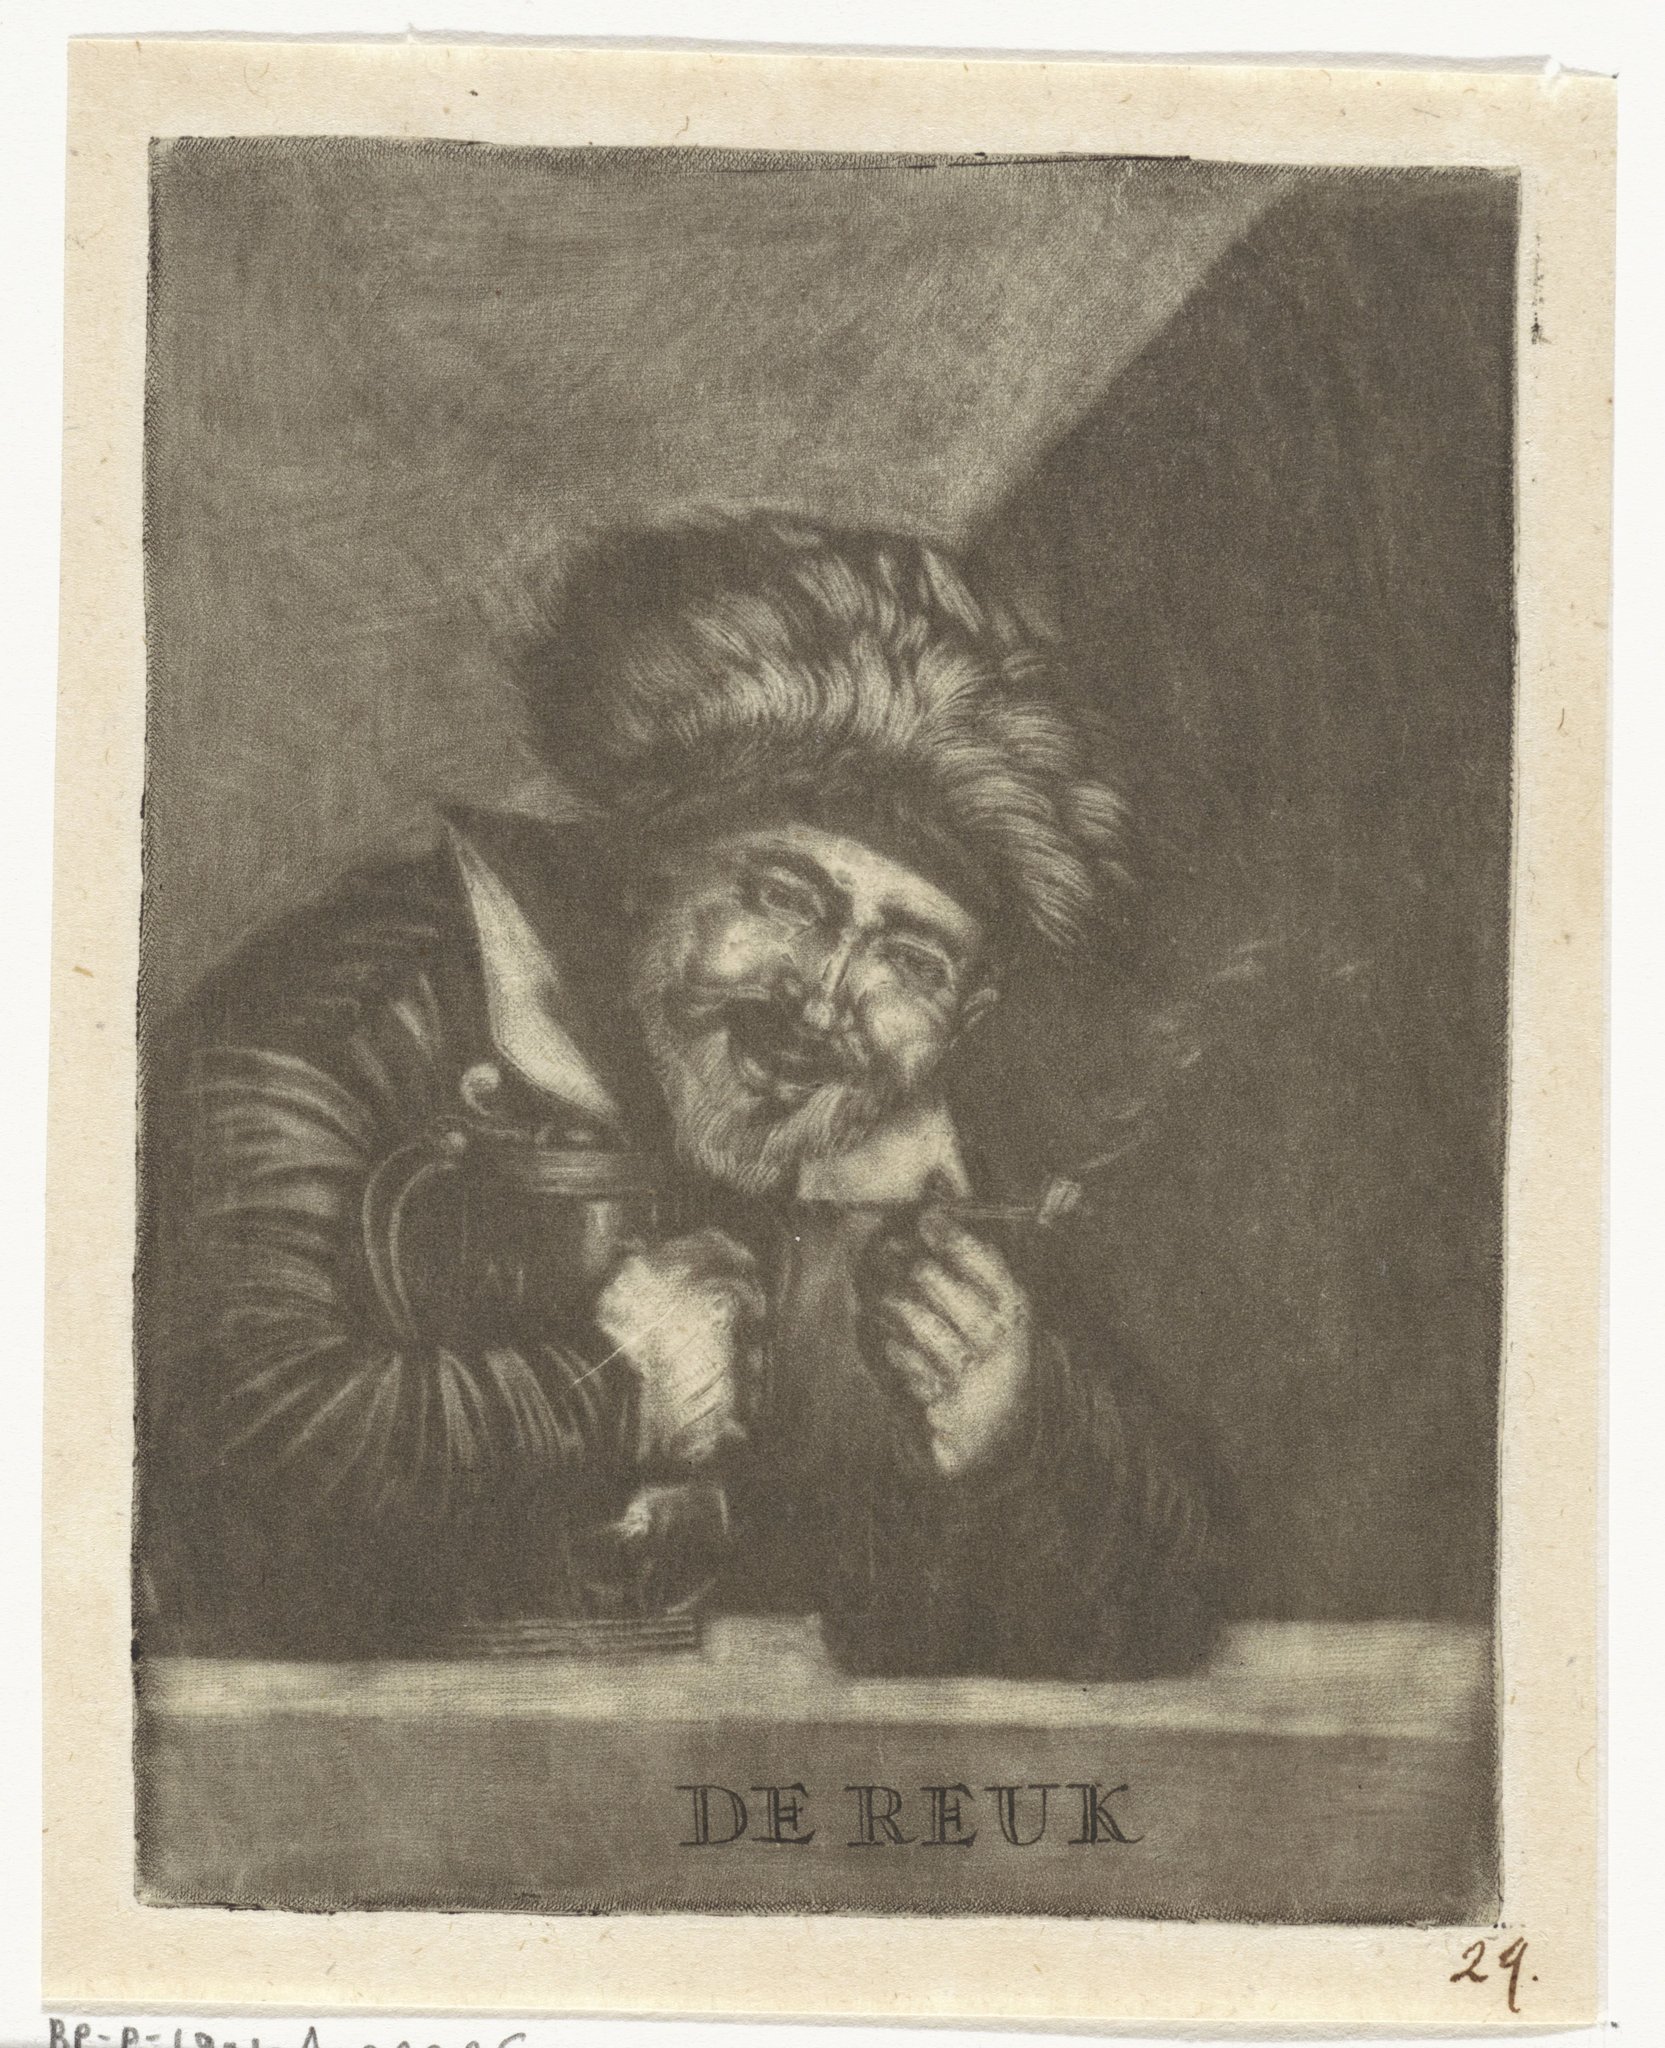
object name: print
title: De vijf zintuigen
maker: pieter pickaert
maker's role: print maker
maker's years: 1668-1737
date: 1680-1715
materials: paper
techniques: mezzotint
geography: amsterdam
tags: smell, smelling (one of the five senses)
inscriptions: collector's mark: Lugt 2228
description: Het zintuig Reuk. Een man, met bontmuts op het hoofd, houdt een tinnen bierkan vast. In de linkerhand houdt hij een pijp.